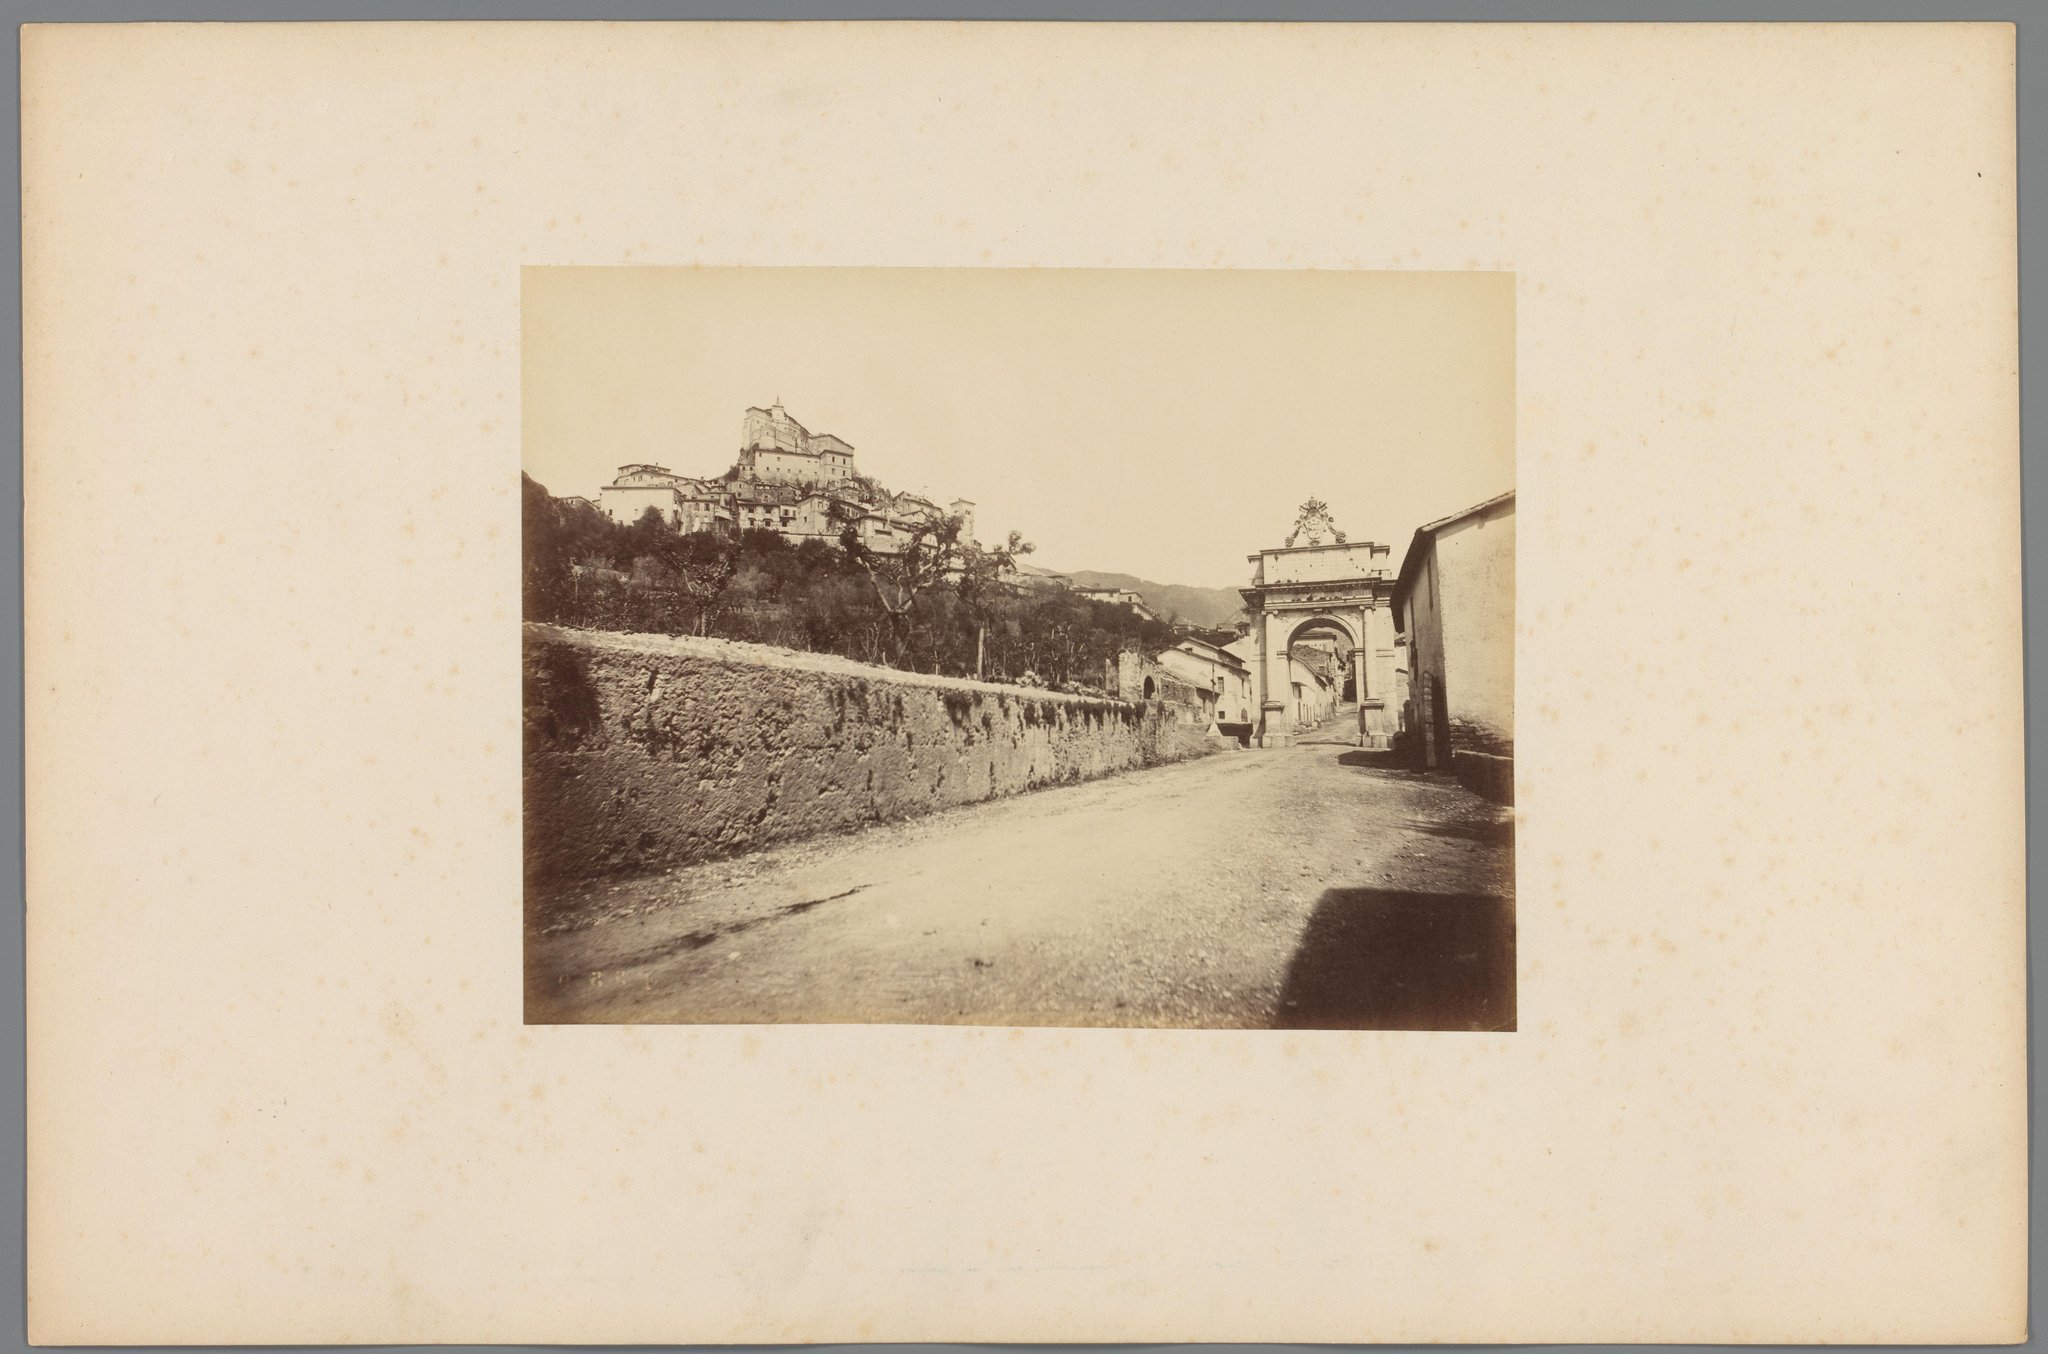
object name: photograph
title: Gezicht op de stadspoort an Subiaco en de Rocca Abbaziale, Italië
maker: Anonymous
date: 1851-1900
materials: cardboard, paper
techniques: albumen print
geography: subiaco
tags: abbey, monastery, convent ~ roman catholic church, fortified city, city-gate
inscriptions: number: ‘1550 [?]’